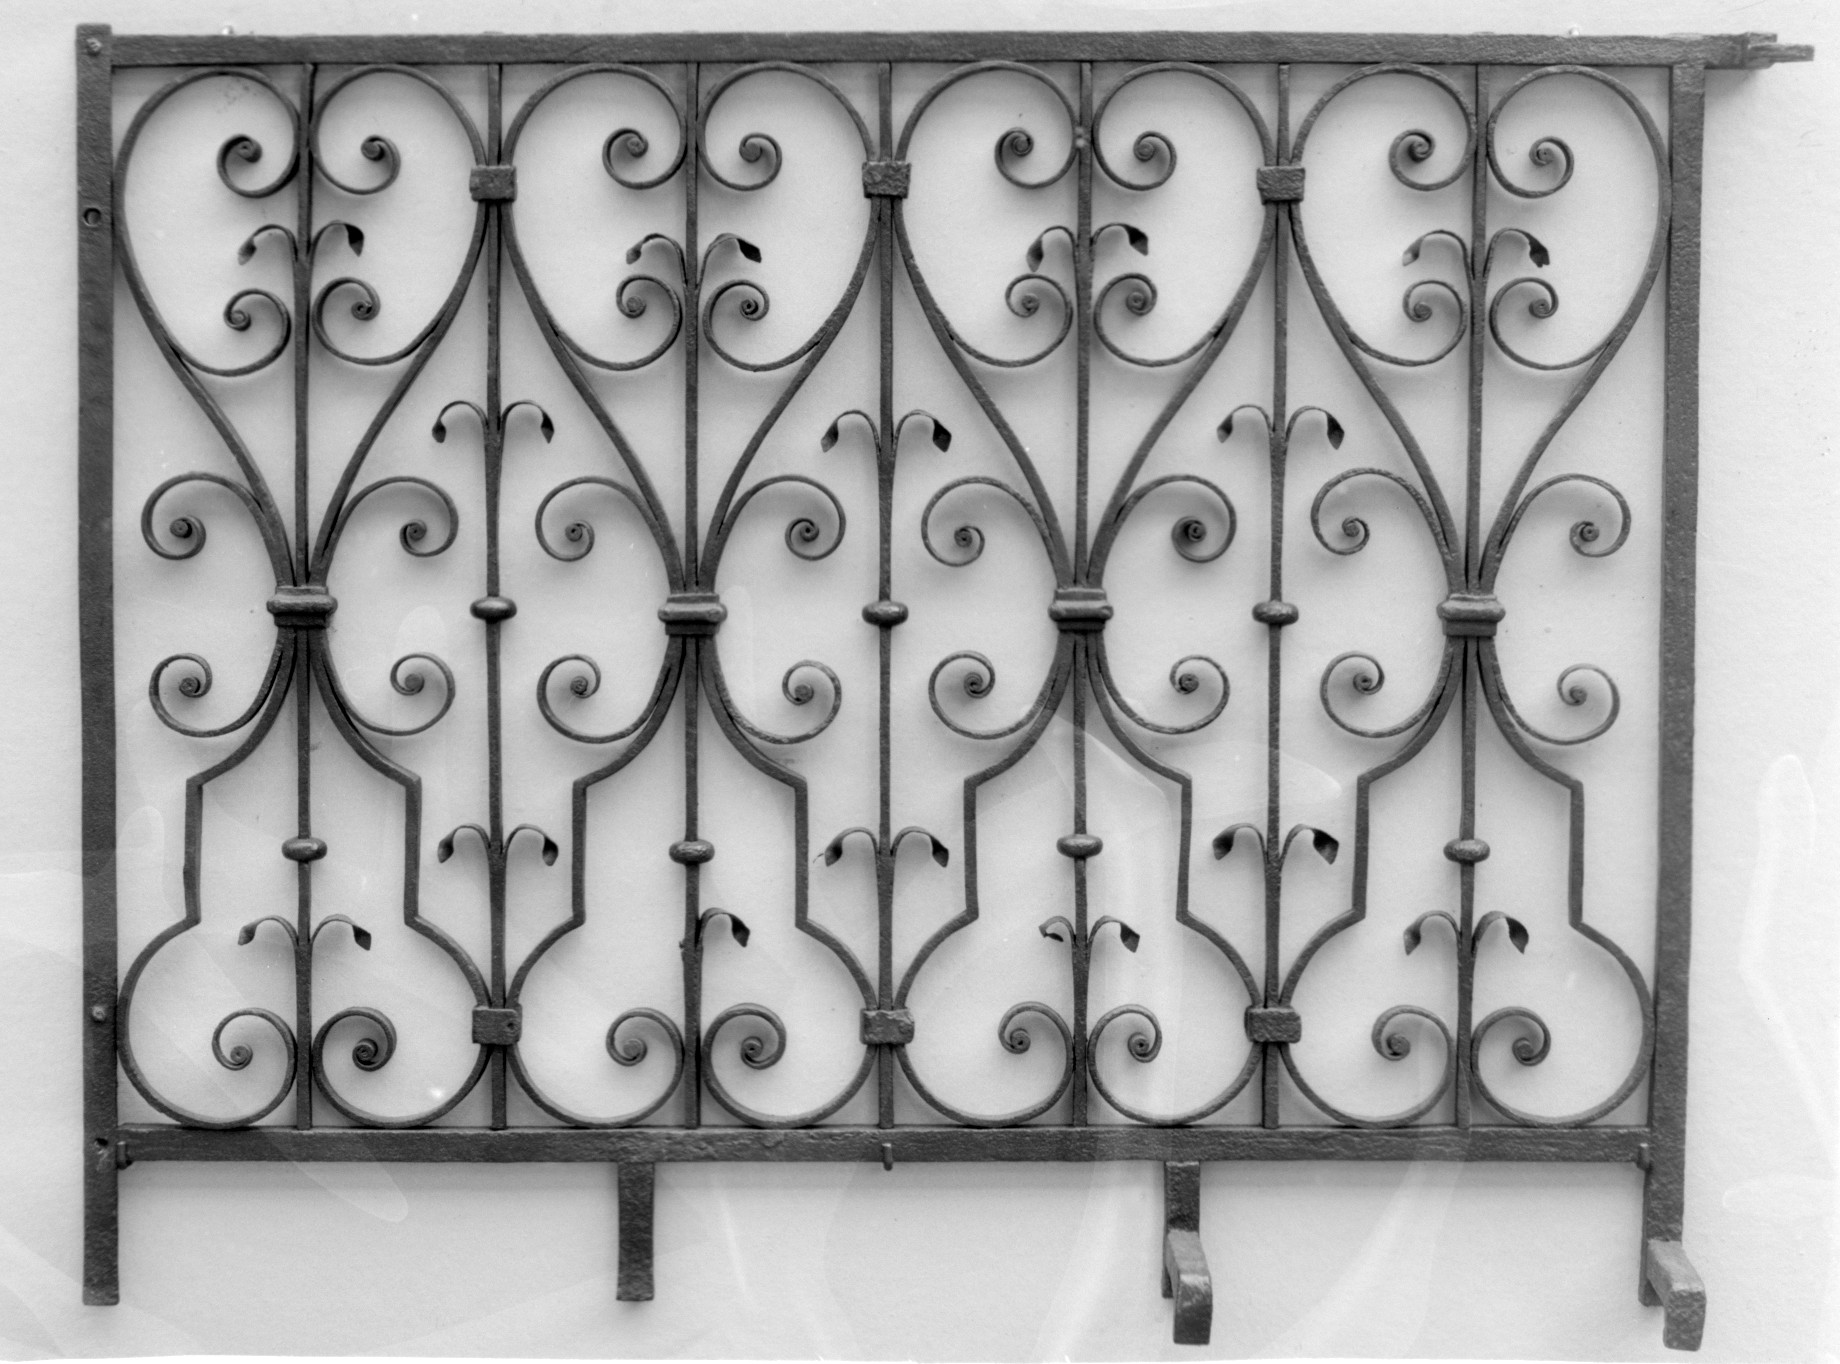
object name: panel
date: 1701-1800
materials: iron